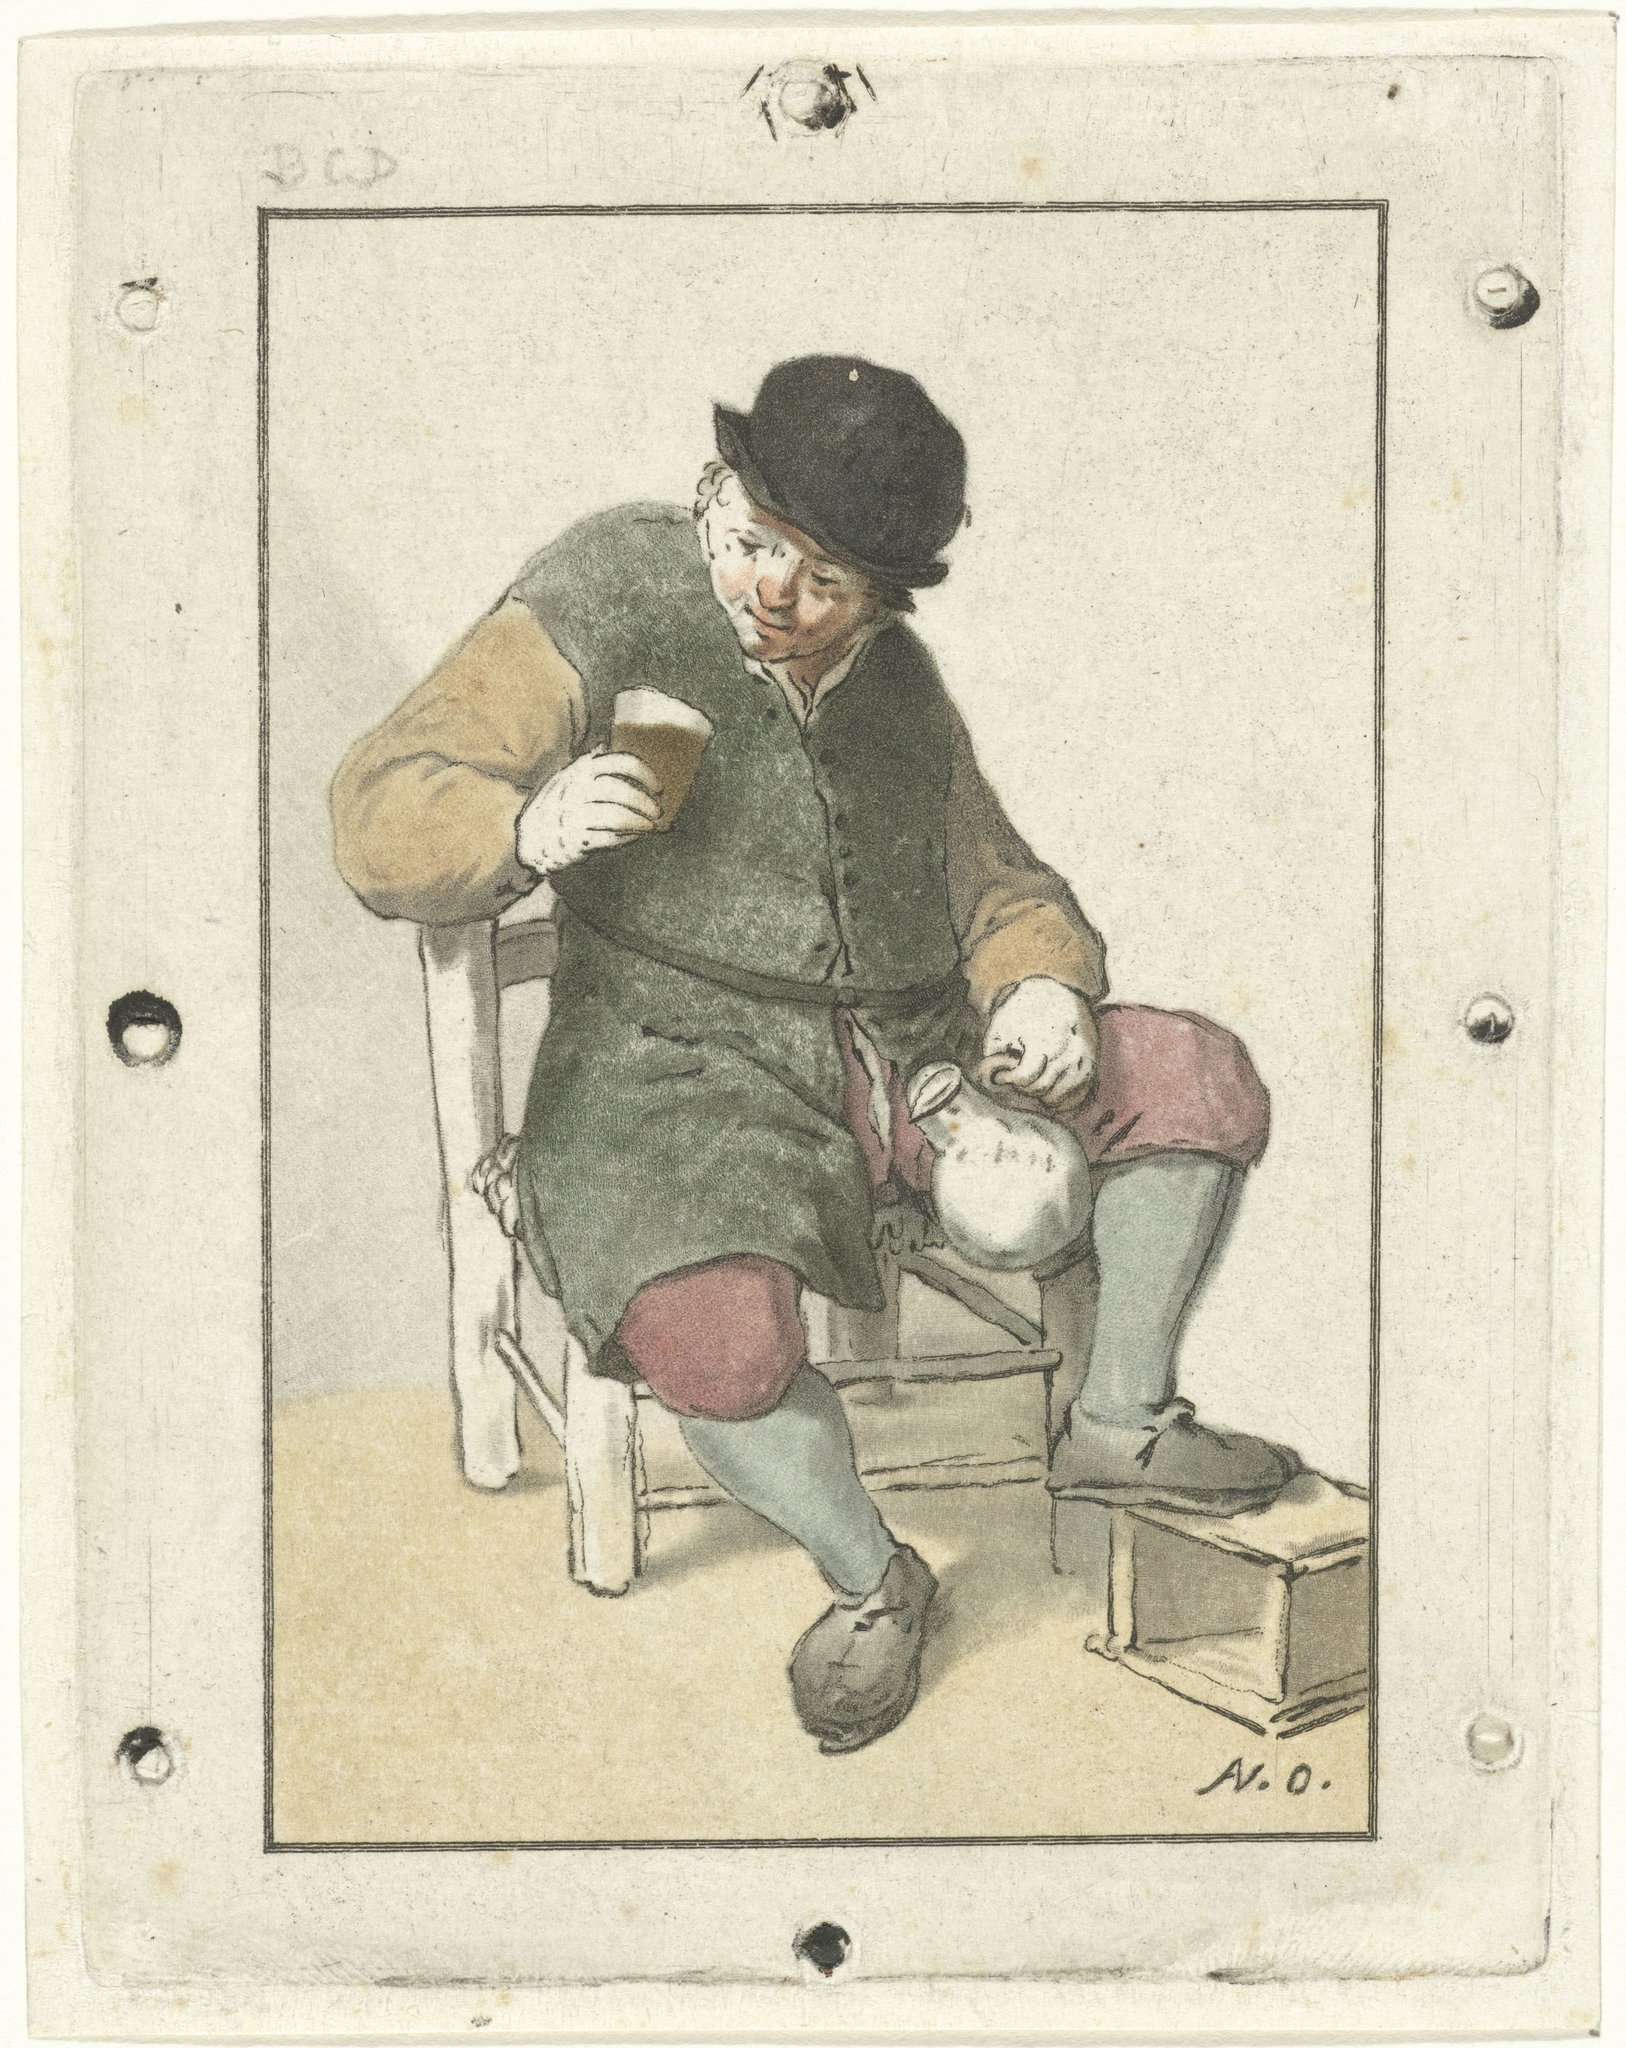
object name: print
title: Zittende boer met kruik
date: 1763-1768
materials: paper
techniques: etching, roulette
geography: amsterdam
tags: sitting figure, jar, jug (used as drinking-vessel)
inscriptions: collector's mark: Lugt 2228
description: Voor deze prenttekening, 'Zittende boer met kruik', maakte Ploos van Amstel vier verschillende platen (A, B, C, en D). Er bestaan afdrukken van één, twee, drie of alle vier de platen in alle mogelijke combinaties. Zie gerelateerde objecten voor de hier gebruikte platen.